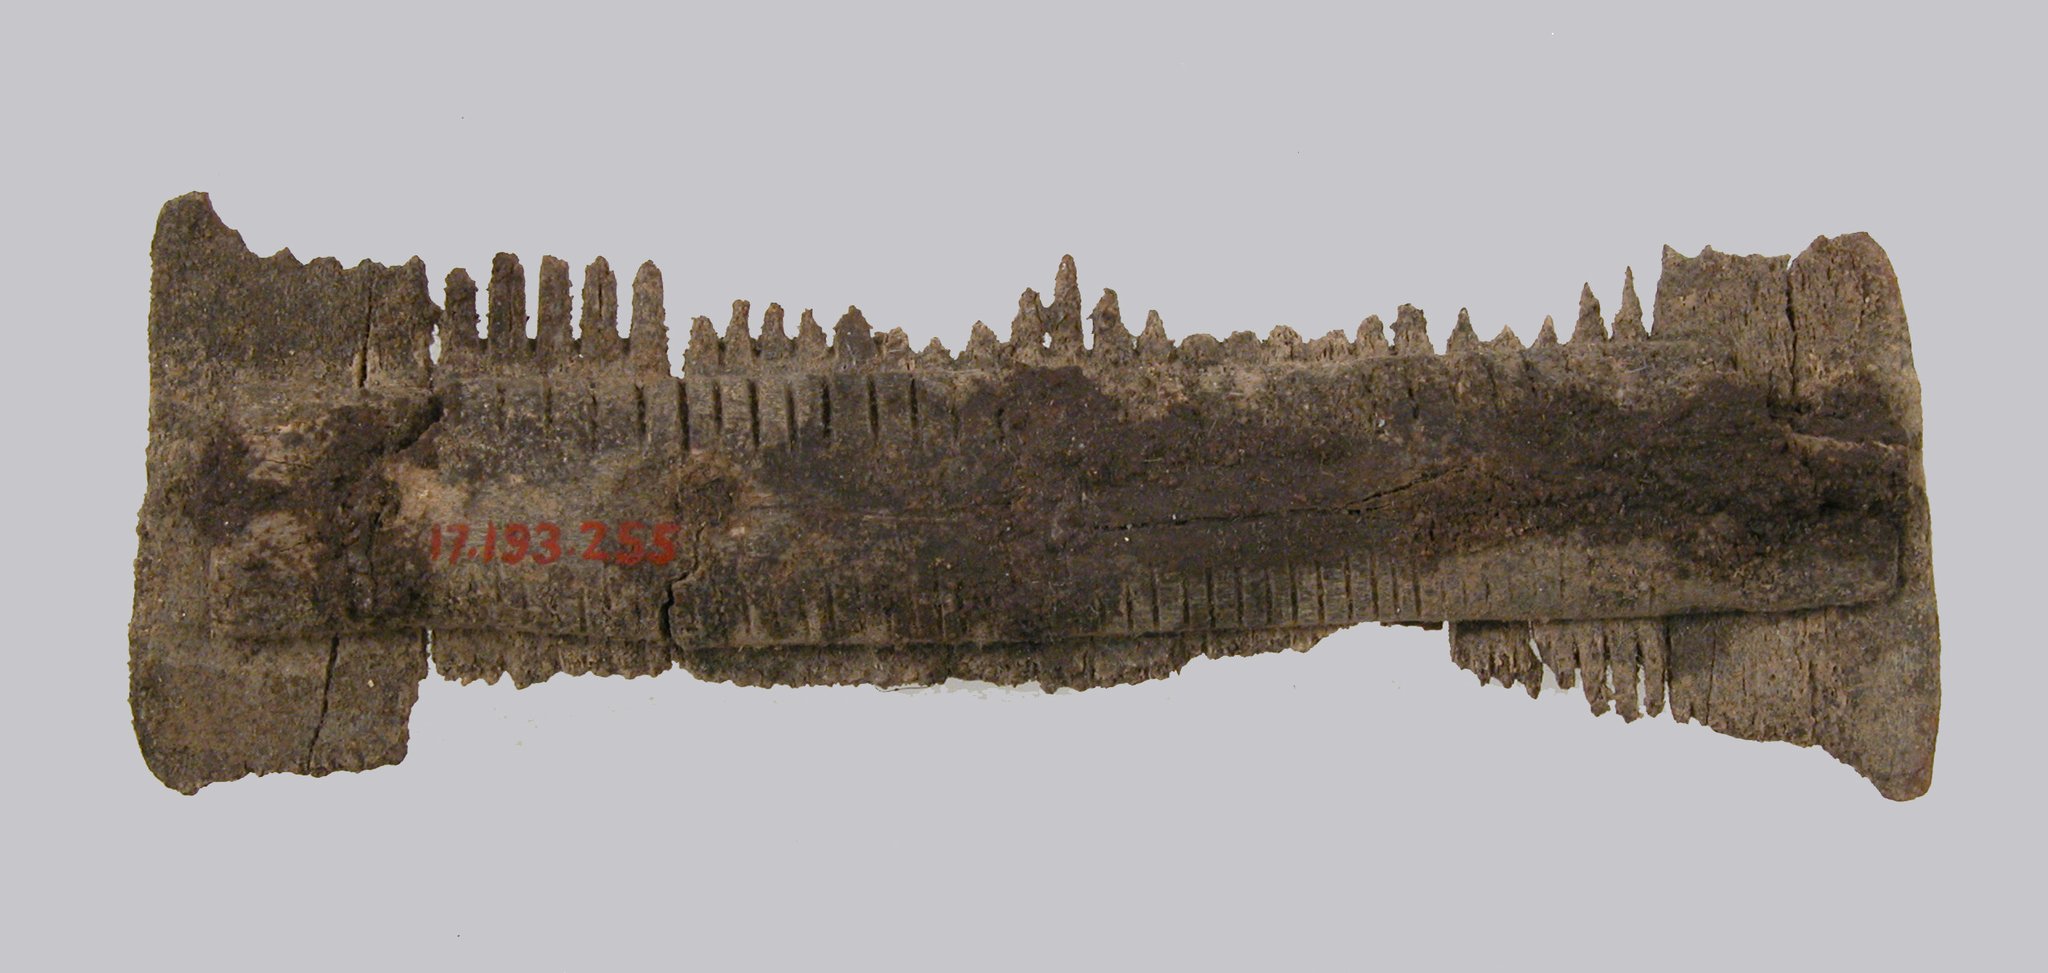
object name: comb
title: Double-Sided Comb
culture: frankish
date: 601-700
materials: bone, iron